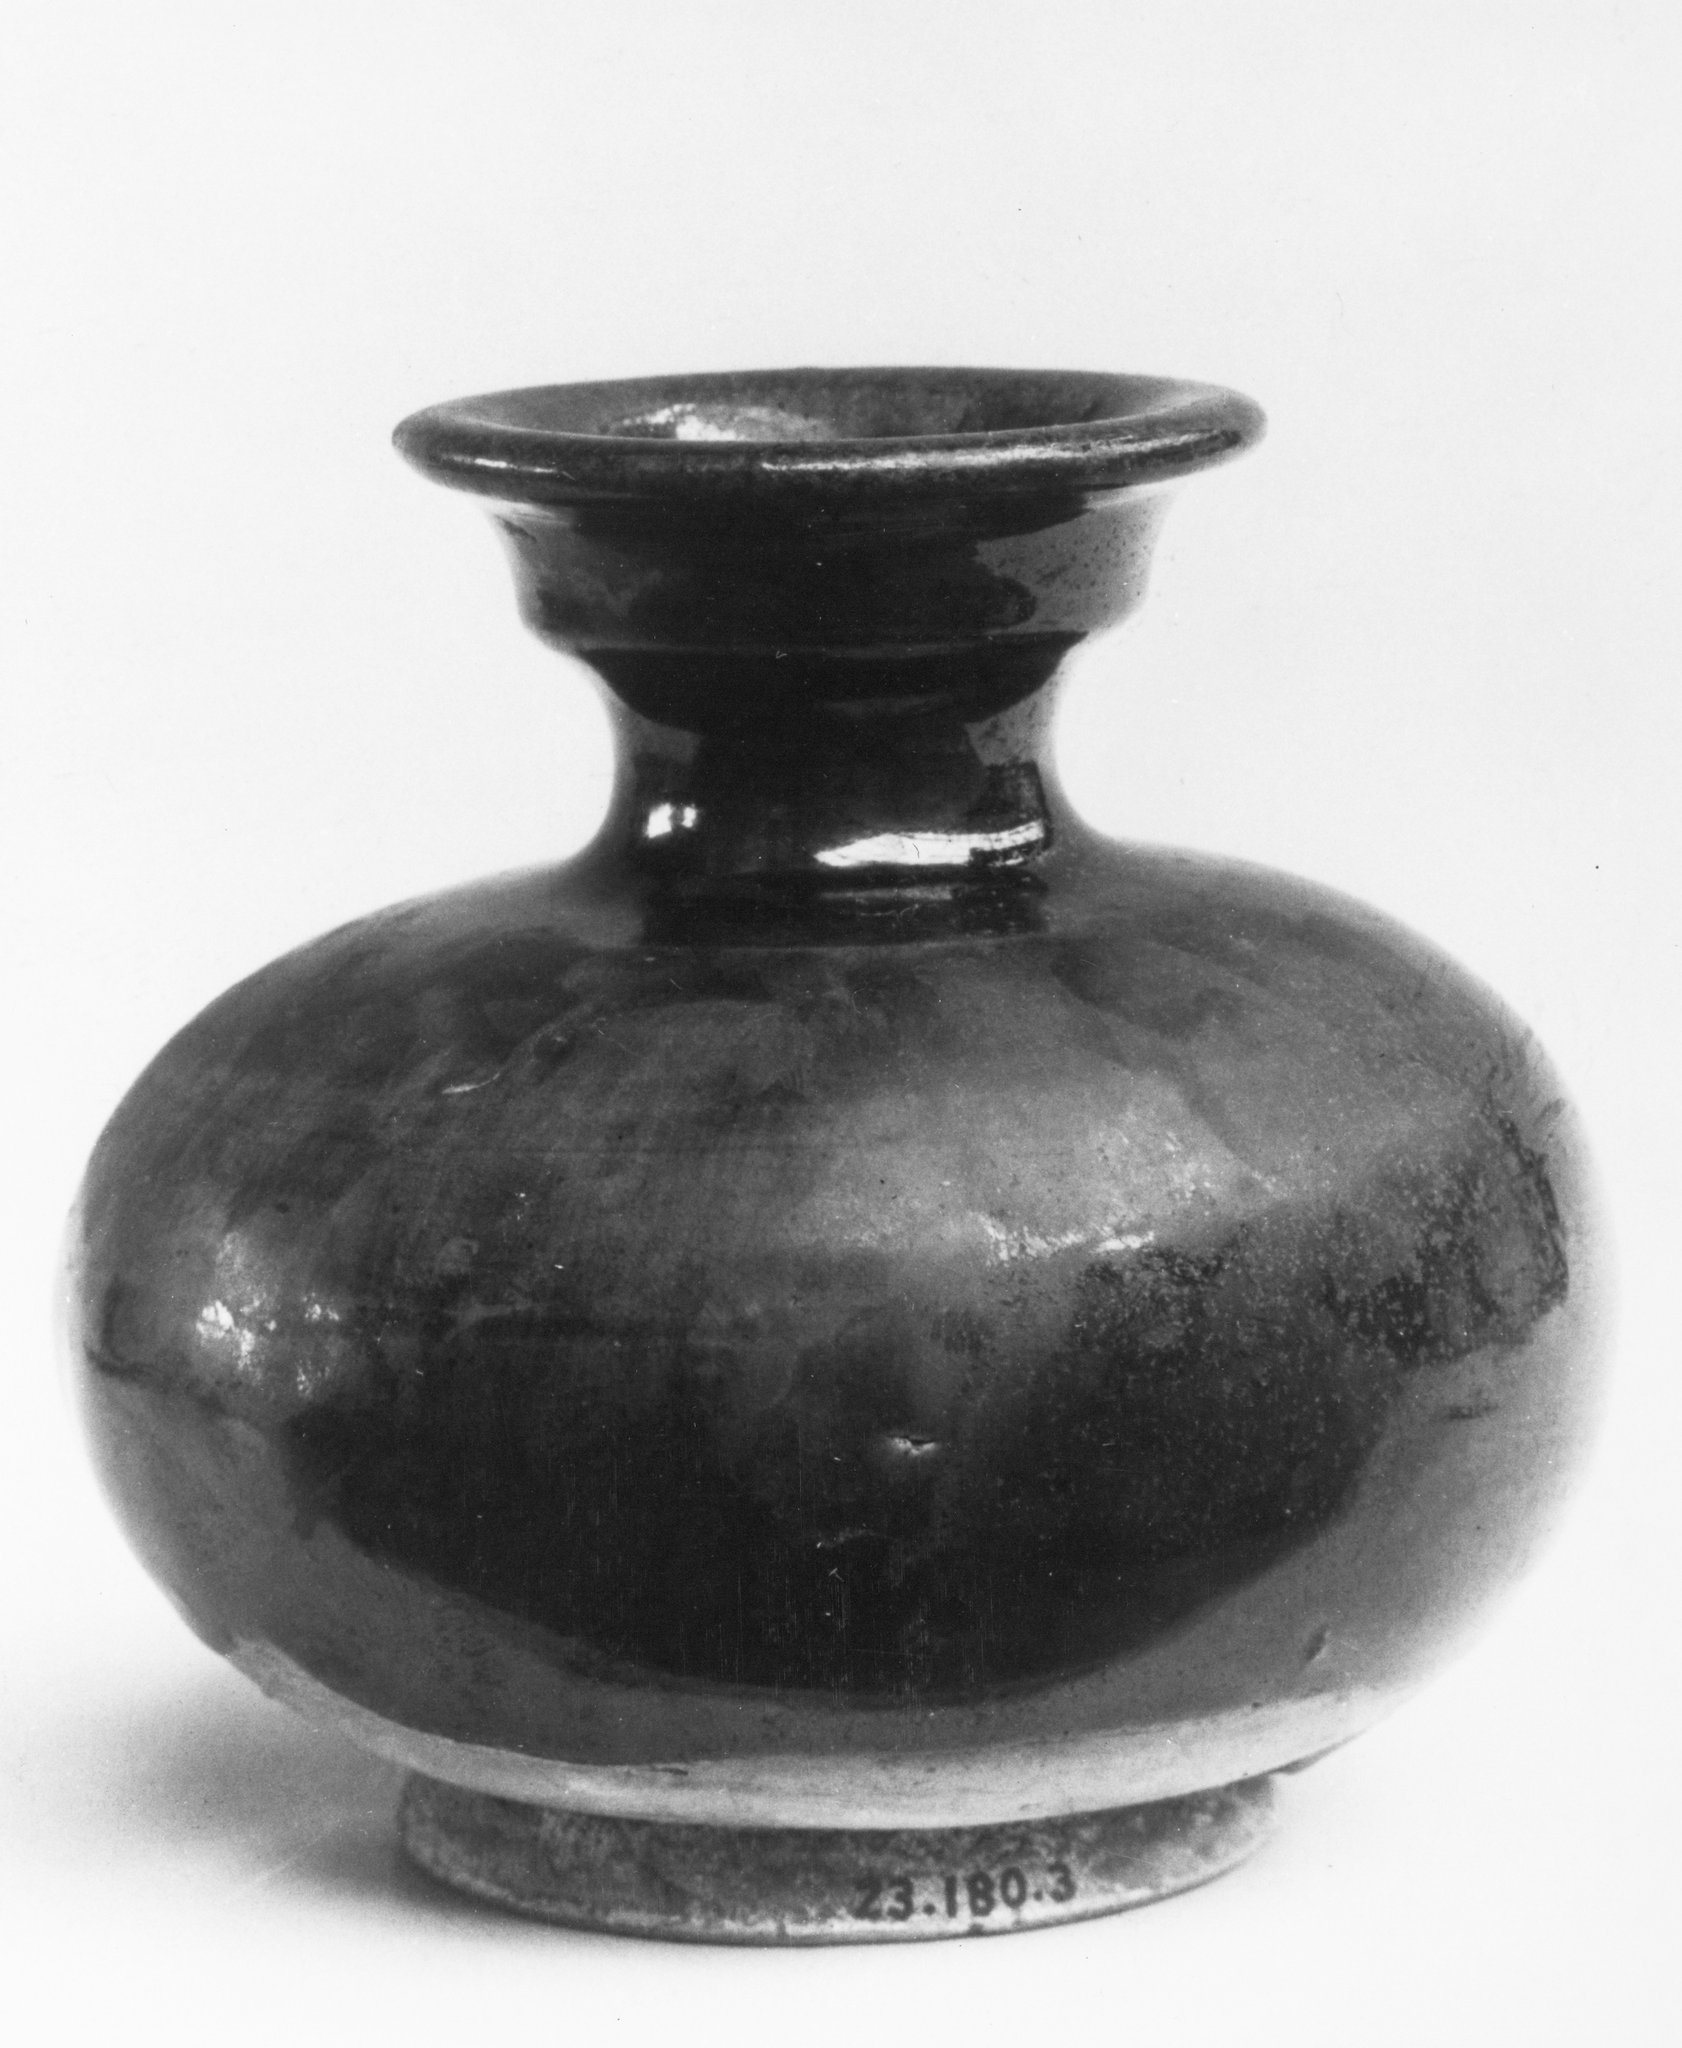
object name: jar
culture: chinese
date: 601-800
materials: earthenware, glaze